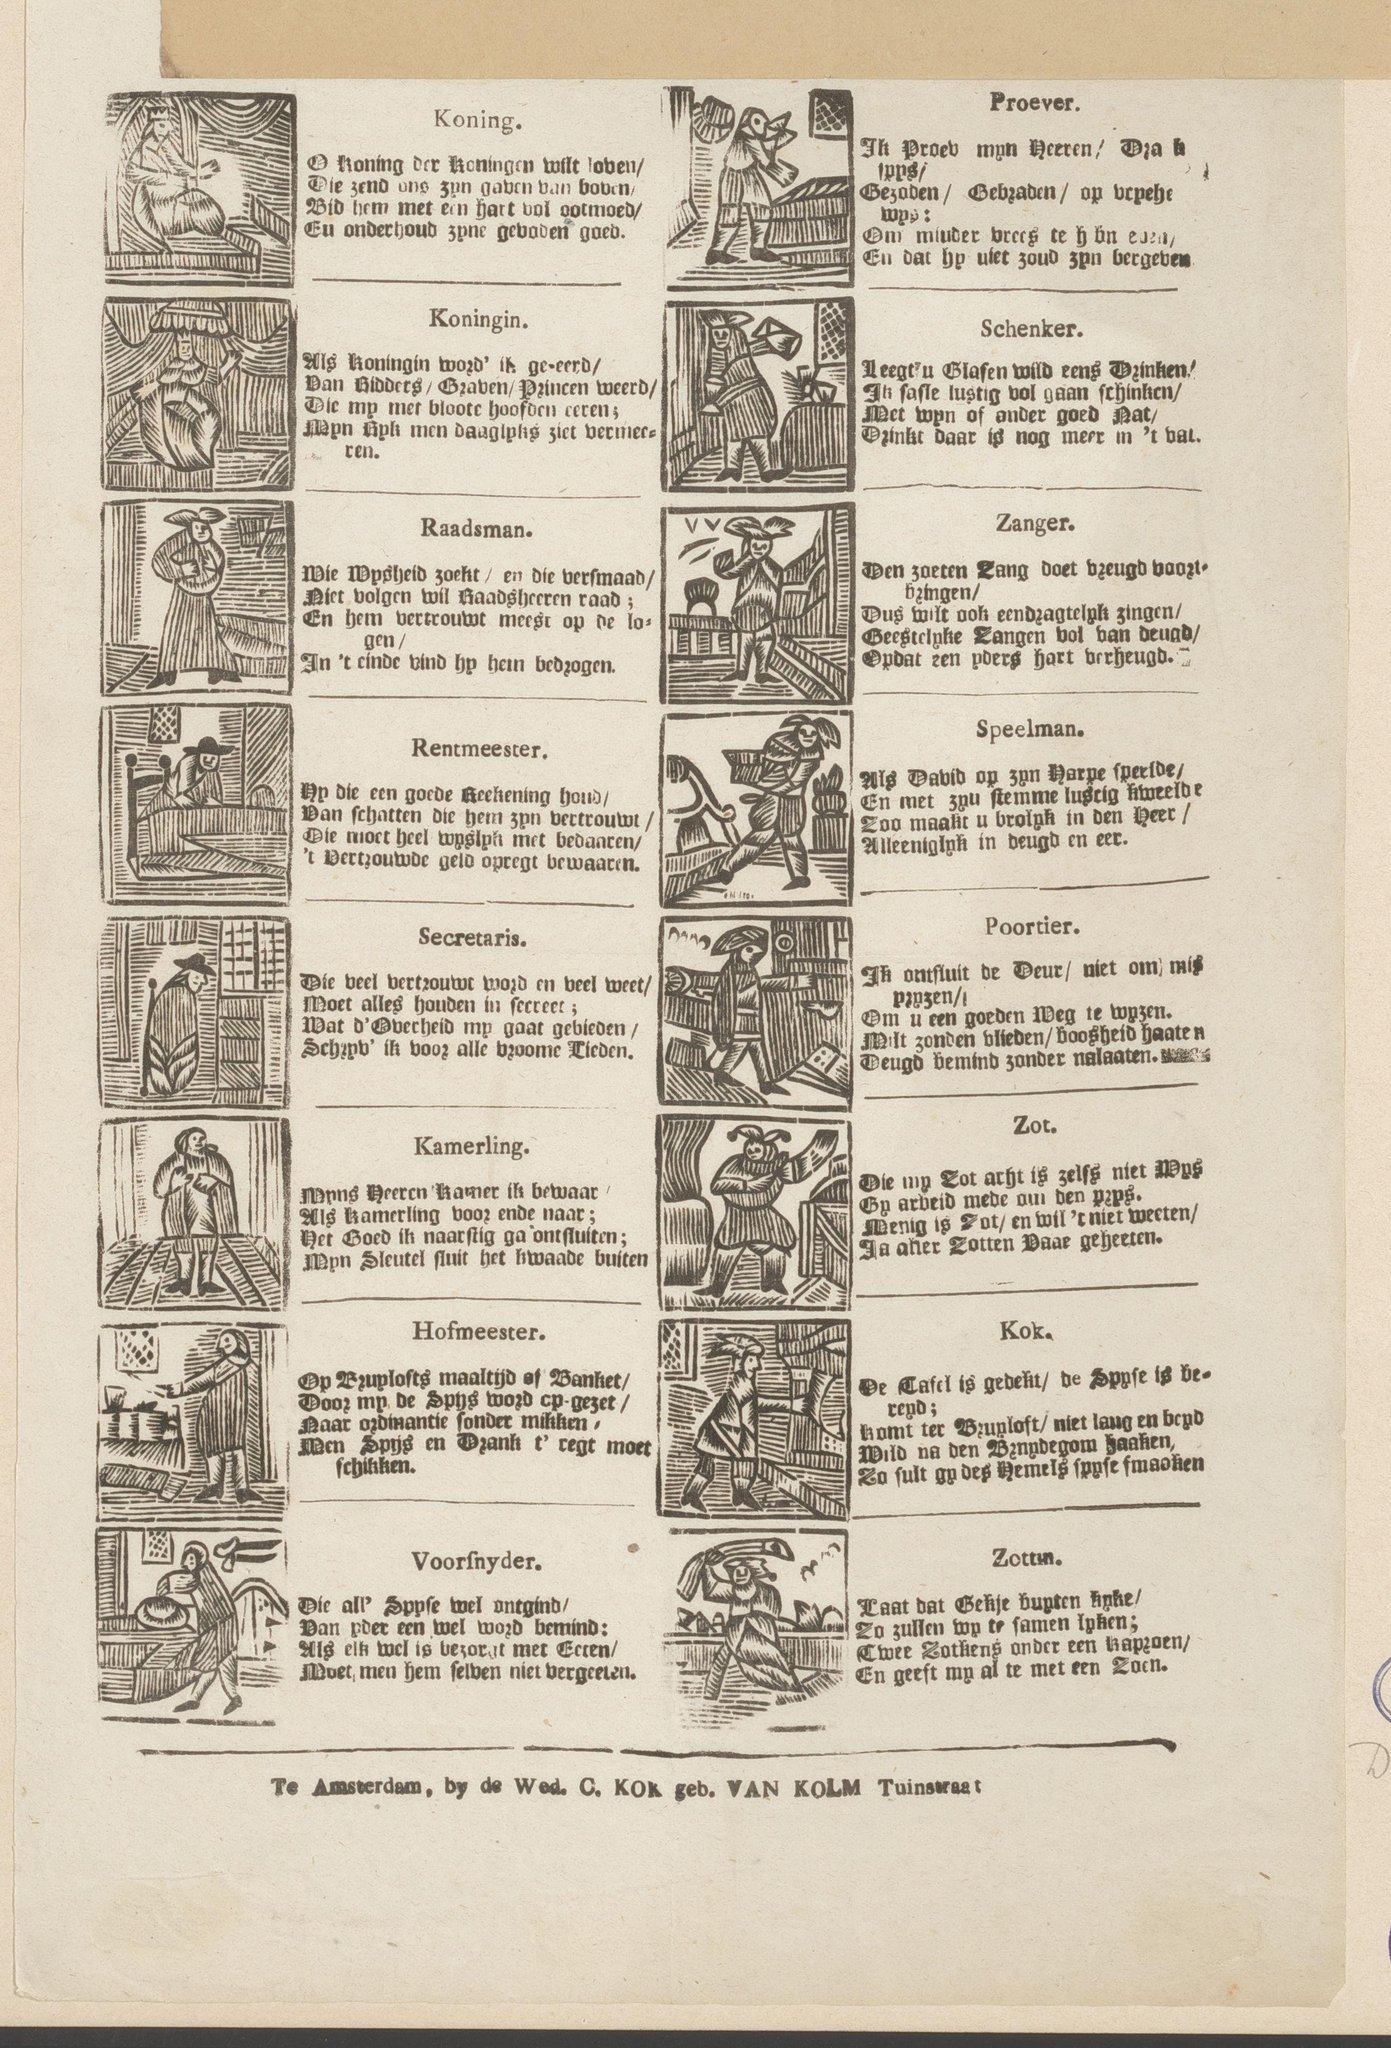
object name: print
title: Trekprent voor het Driekoningenfeest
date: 1842-1866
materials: paper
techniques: letterpress printing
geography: netherlands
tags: epiphany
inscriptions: collector's mark, collector's mark: Lugt 1641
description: Trekprent. Blad met rollen en verzen voor het Driekoningenfeest. Twee kolommen met acht vignetten met beroepen en versjes, beginnend met de koning en eindigend met de zottin. De zestien rollen werden losgeknipt en opgerold en in een bus gedaan, waarna de deelnemers een lot trokken met hun rol voor het feest. Wie de koning trok kreeg de kroon op het hoofd en was op het feest de koning. Onderwerpsrubrieken binnen de Atlas Zeden en Gewoonten: Volksfeesten; Driekoningen.